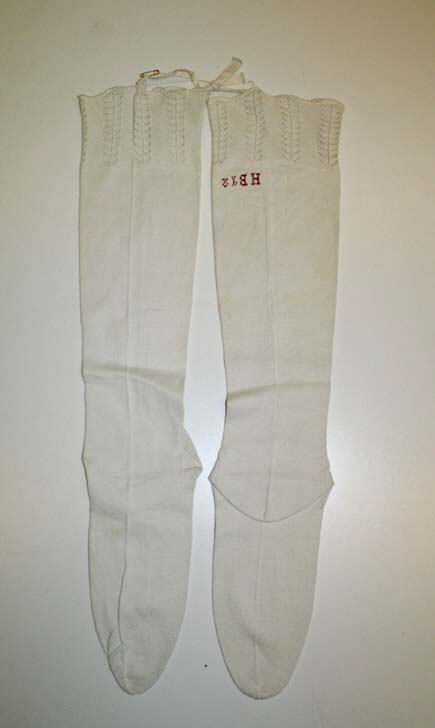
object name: stocking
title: Stockings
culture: swiss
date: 1860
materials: cotton